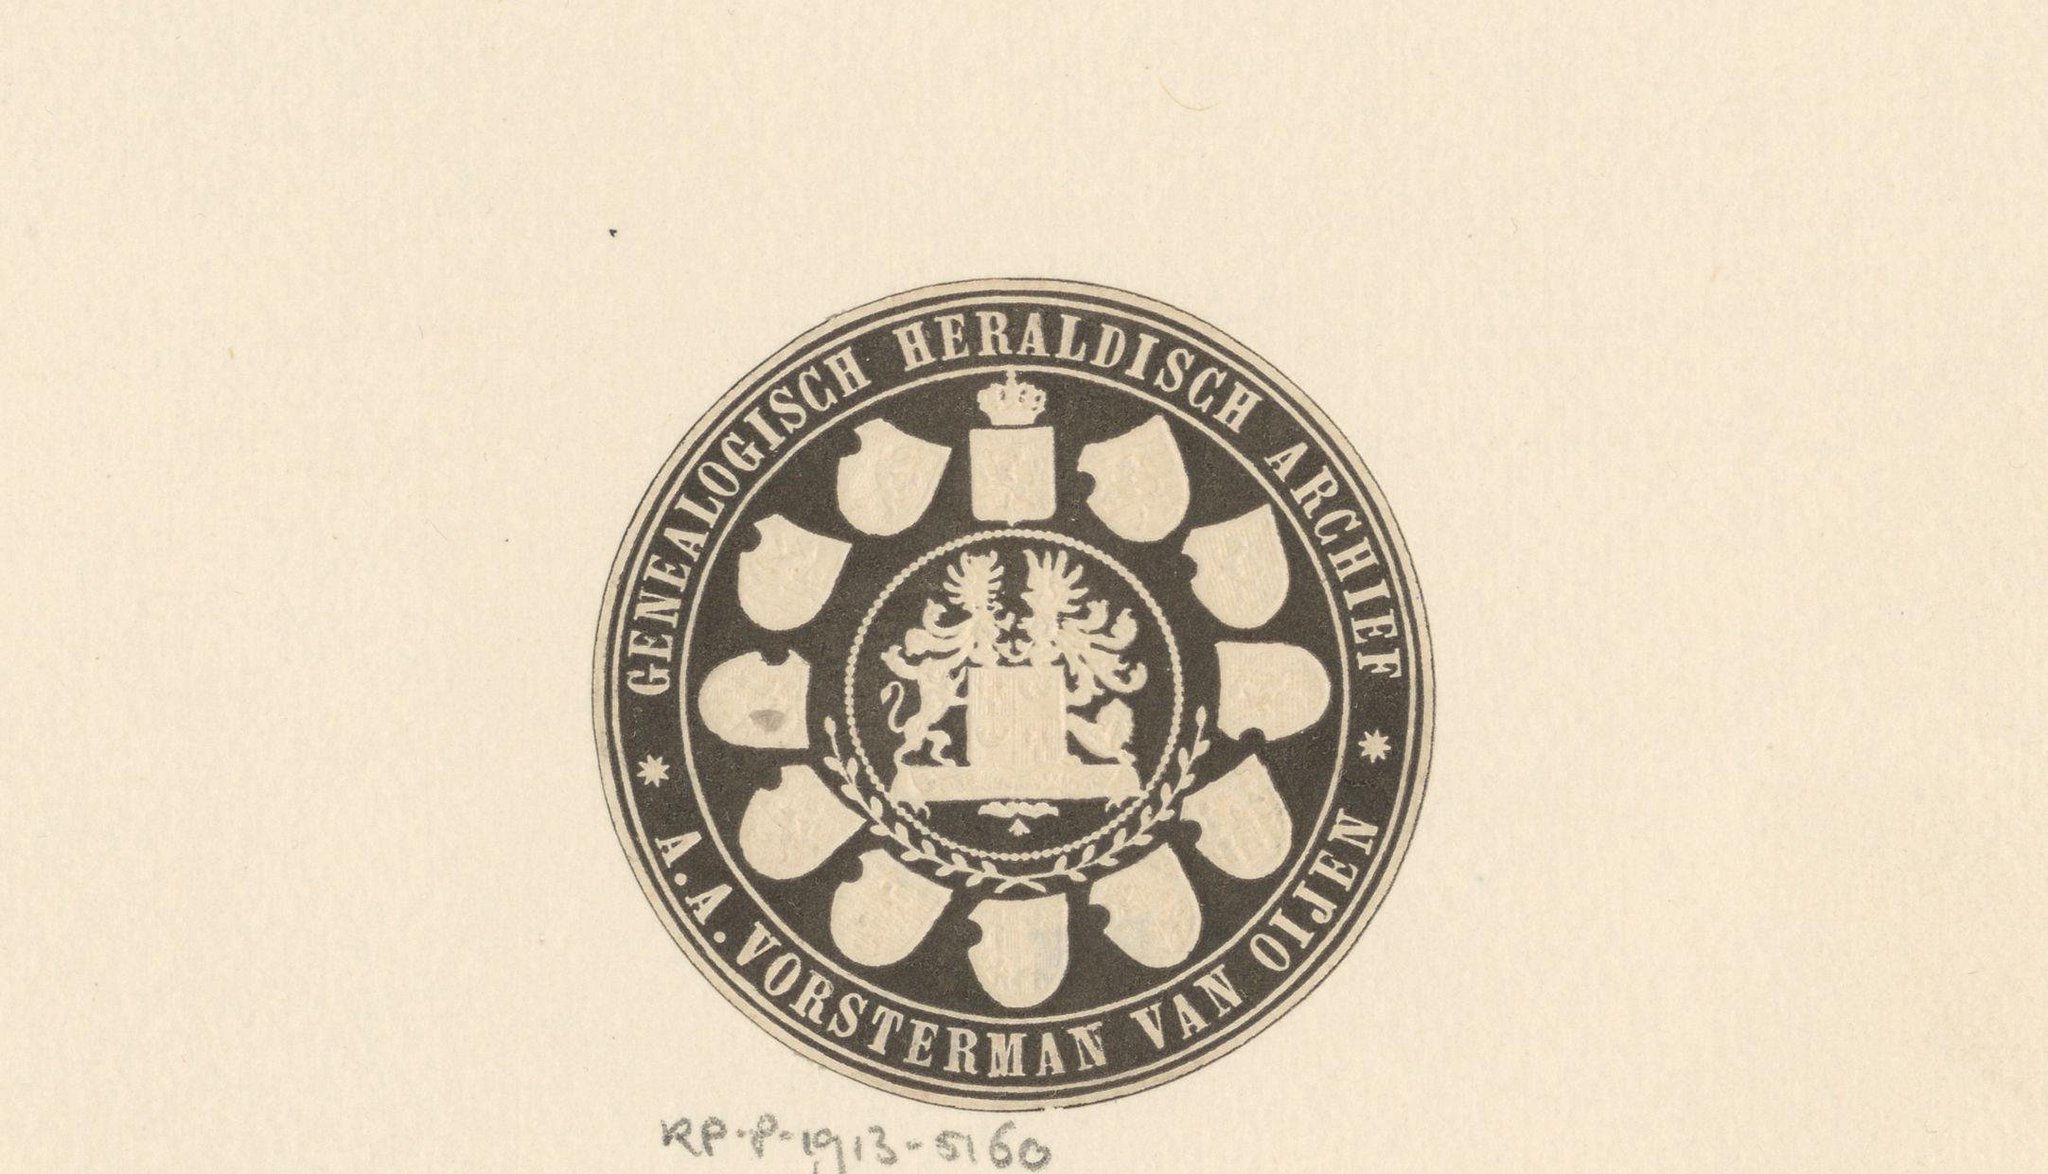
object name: bookplate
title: Ex libris van A.A. Vorsterman van Oijen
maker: Anonymous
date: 1855-1912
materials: paper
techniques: printing block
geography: netherlands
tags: maarssen, antonie abraham vorsterman van oijen, armorial bearing, heraldry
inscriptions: collector's mark: Lugt 2760, collector's mark: Lugt 2233